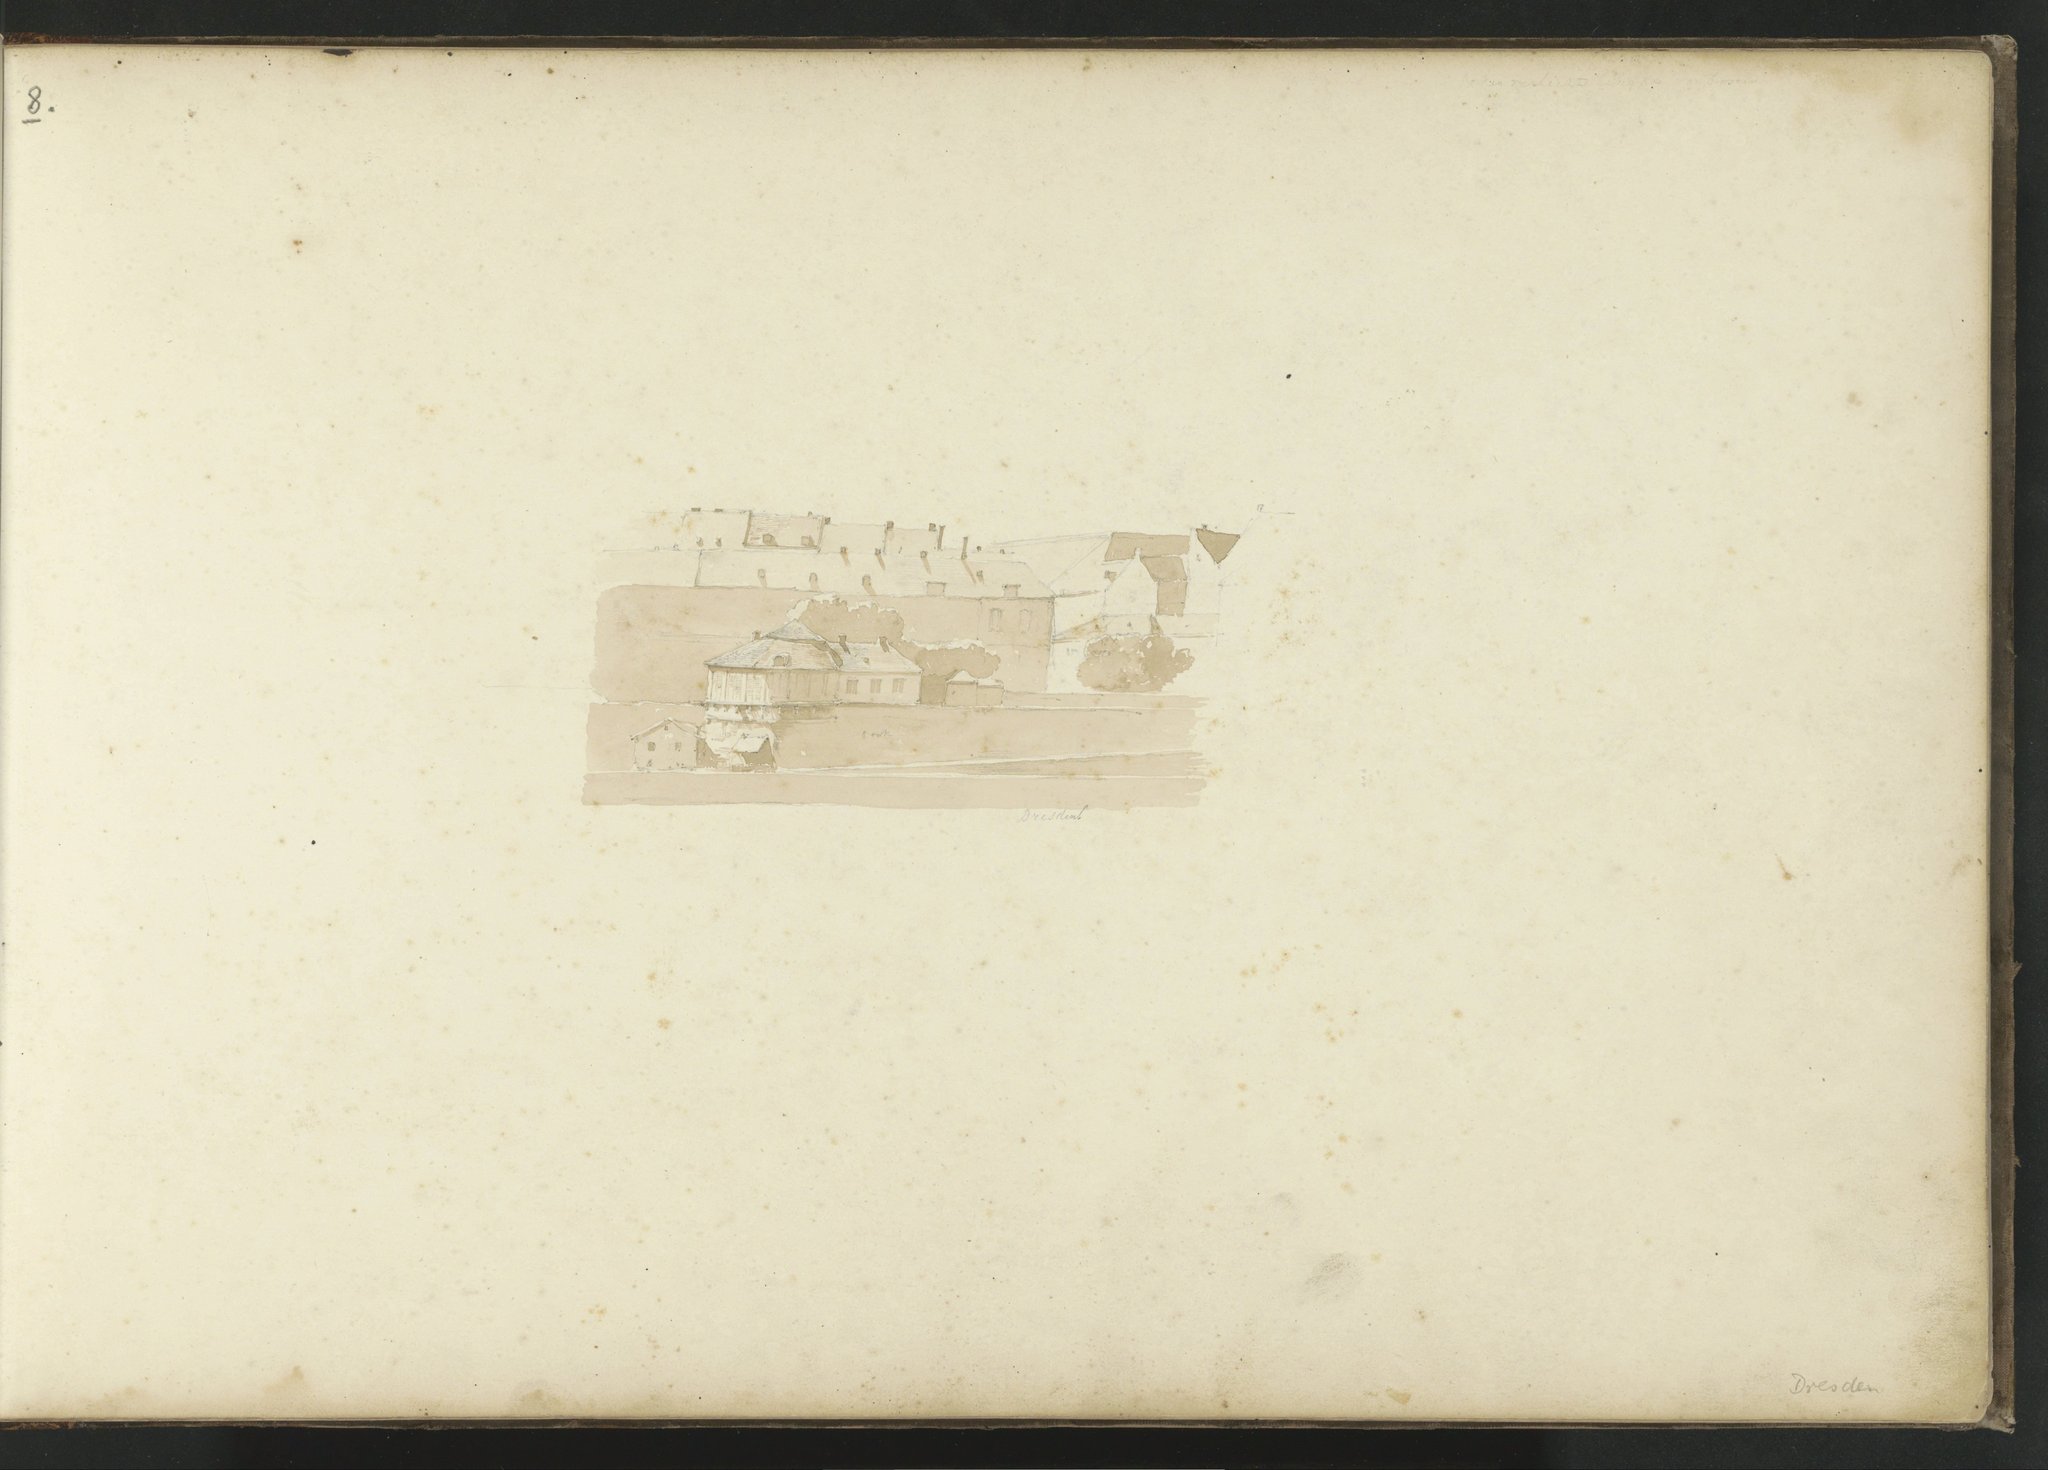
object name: sketchbook leaf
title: Huizen aan een kade van de Elbe te Dresden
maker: kasparus karsen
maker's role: draughtsman, painter, print maker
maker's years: 1810-1896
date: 1820-1896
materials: paper, pencil, watercolor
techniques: brush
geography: dresden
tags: the usual house or row of houses, quay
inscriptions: annotation: ‘Dresden’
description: Blad 8 recto uit een schetsboek met 68 bladen.